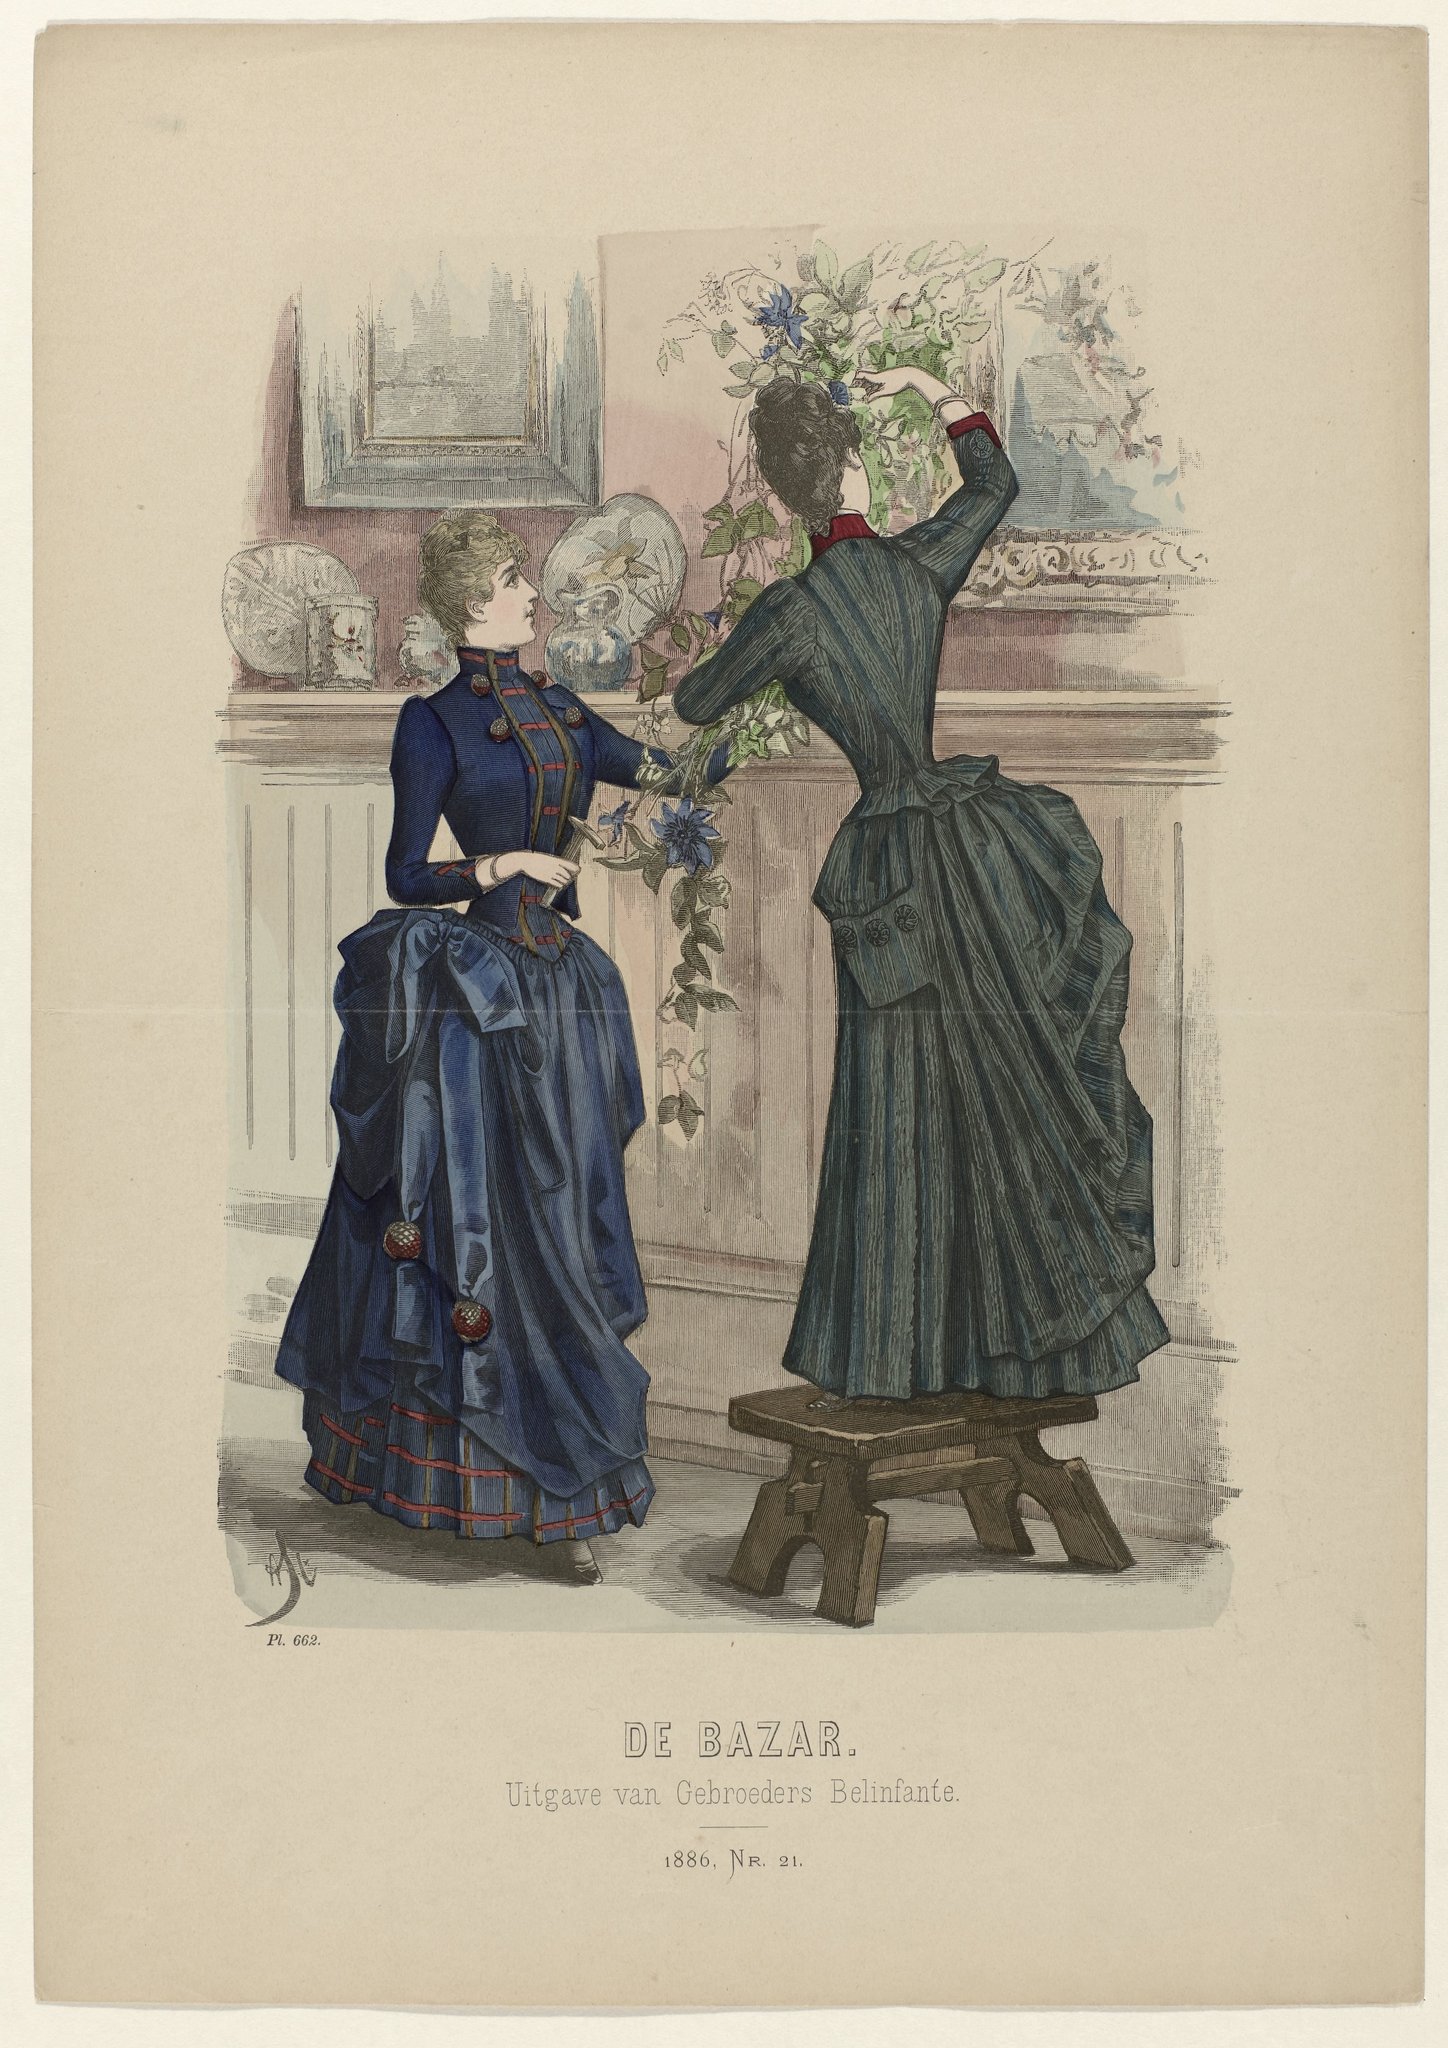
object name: fashion print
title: De Bazar, 1886, Nr. 21, Pl. 662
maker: Anonymous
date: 1886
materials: paper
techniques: hand coloring, engraving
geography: the hague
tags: fashion plates, dress, gown (+ women's clothes)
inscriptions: caption: ‘DE BAZAR. / Uitgave van Gebroeders Belinfante. / 1886, Nr. 21’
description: Prent uit het modetijdschrift De Bazar, geïllustreerd Tijdschrift voor Modes en Handwerken (1857-1900).